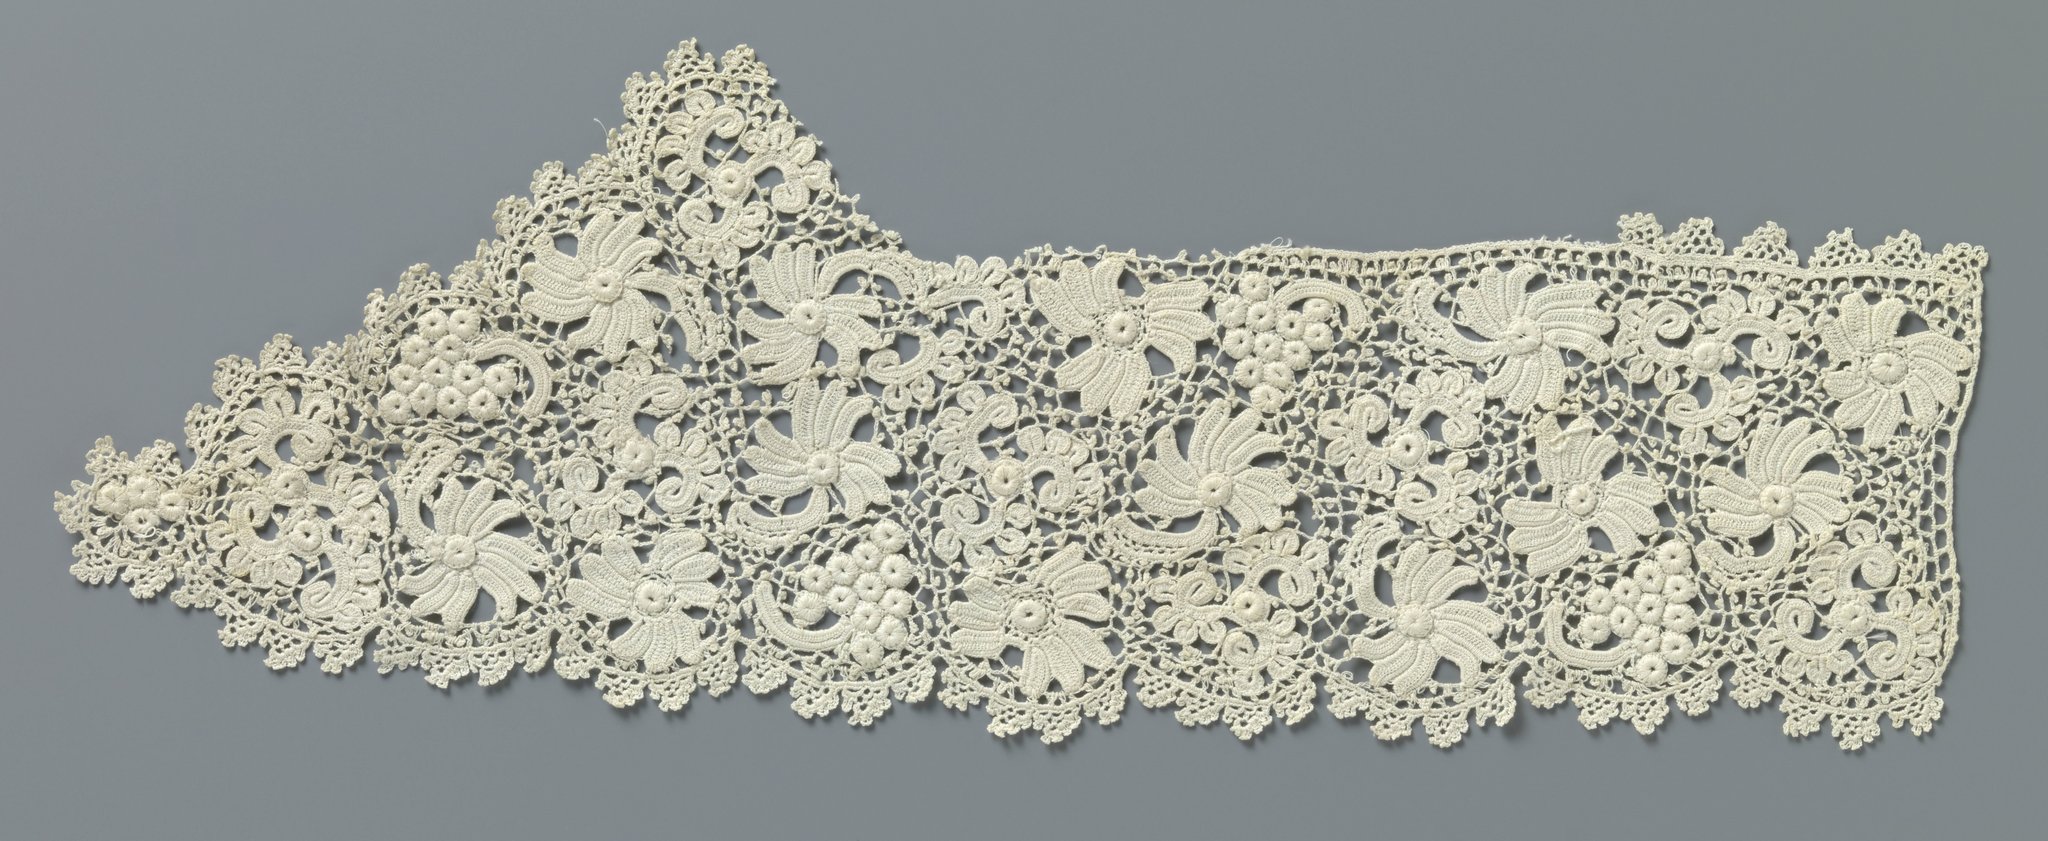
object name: strip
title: Strook gehaakte kant met bloemen en druiventros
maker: Anonymous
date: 1890-1909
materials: cotton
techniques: crocheted lace, irish crochet lace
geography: ireland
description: Het is een aanname dat deze Ierse gehaakte kant ook daadwerkelijk in Ierland is gemaakt. Ierse gehaakte kant kent zijn oorsprong rond 1760 en kwam vanaf 1840 in ontwikkeling. Aangezien volgens Martine Bruggeman (Kant in Europa) de Ierse haakindustrie aan het eind van de 19e eeuw gereorganiseerd werd en in populariteit groeide, is het hier beschreven stuk gedateerd rond 1890, tot 1909 vanwege de datering in het eerste decennium van populariteit van Ierse gehaakte kant volgens het Kantlexicon (Johan Coene).